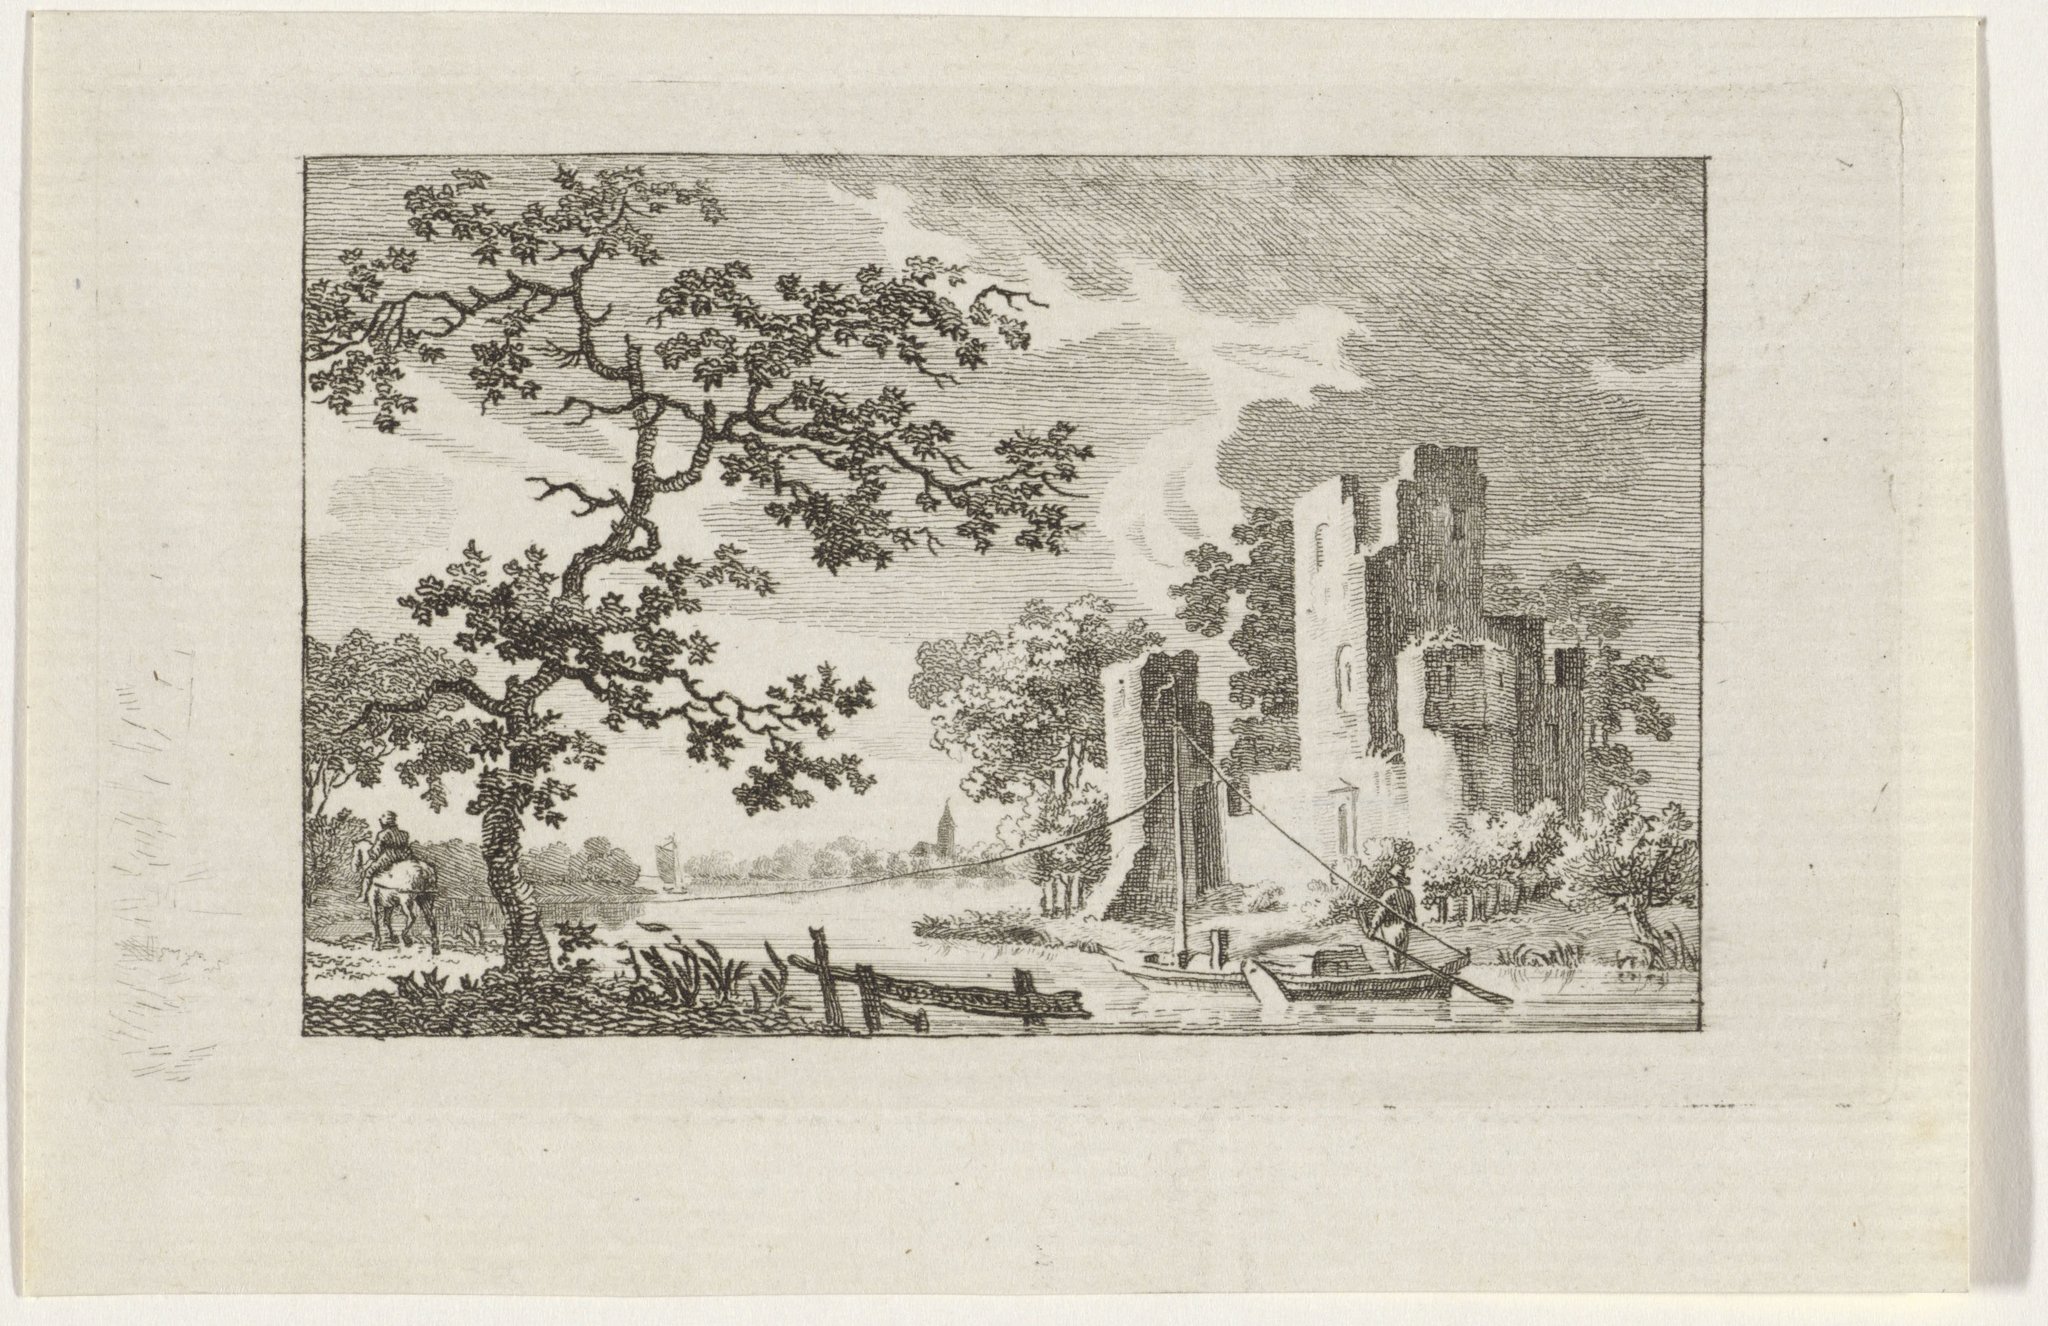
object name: print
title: Ruïne aan een trekvaart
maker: jacob elias van varelen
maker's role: draughtsman, print maker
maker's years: 1757-1840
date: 1799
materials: paper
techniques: etching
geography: haarlem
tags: river, landscape with ruins, towing path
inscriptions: collector's mark: Lugt 2228